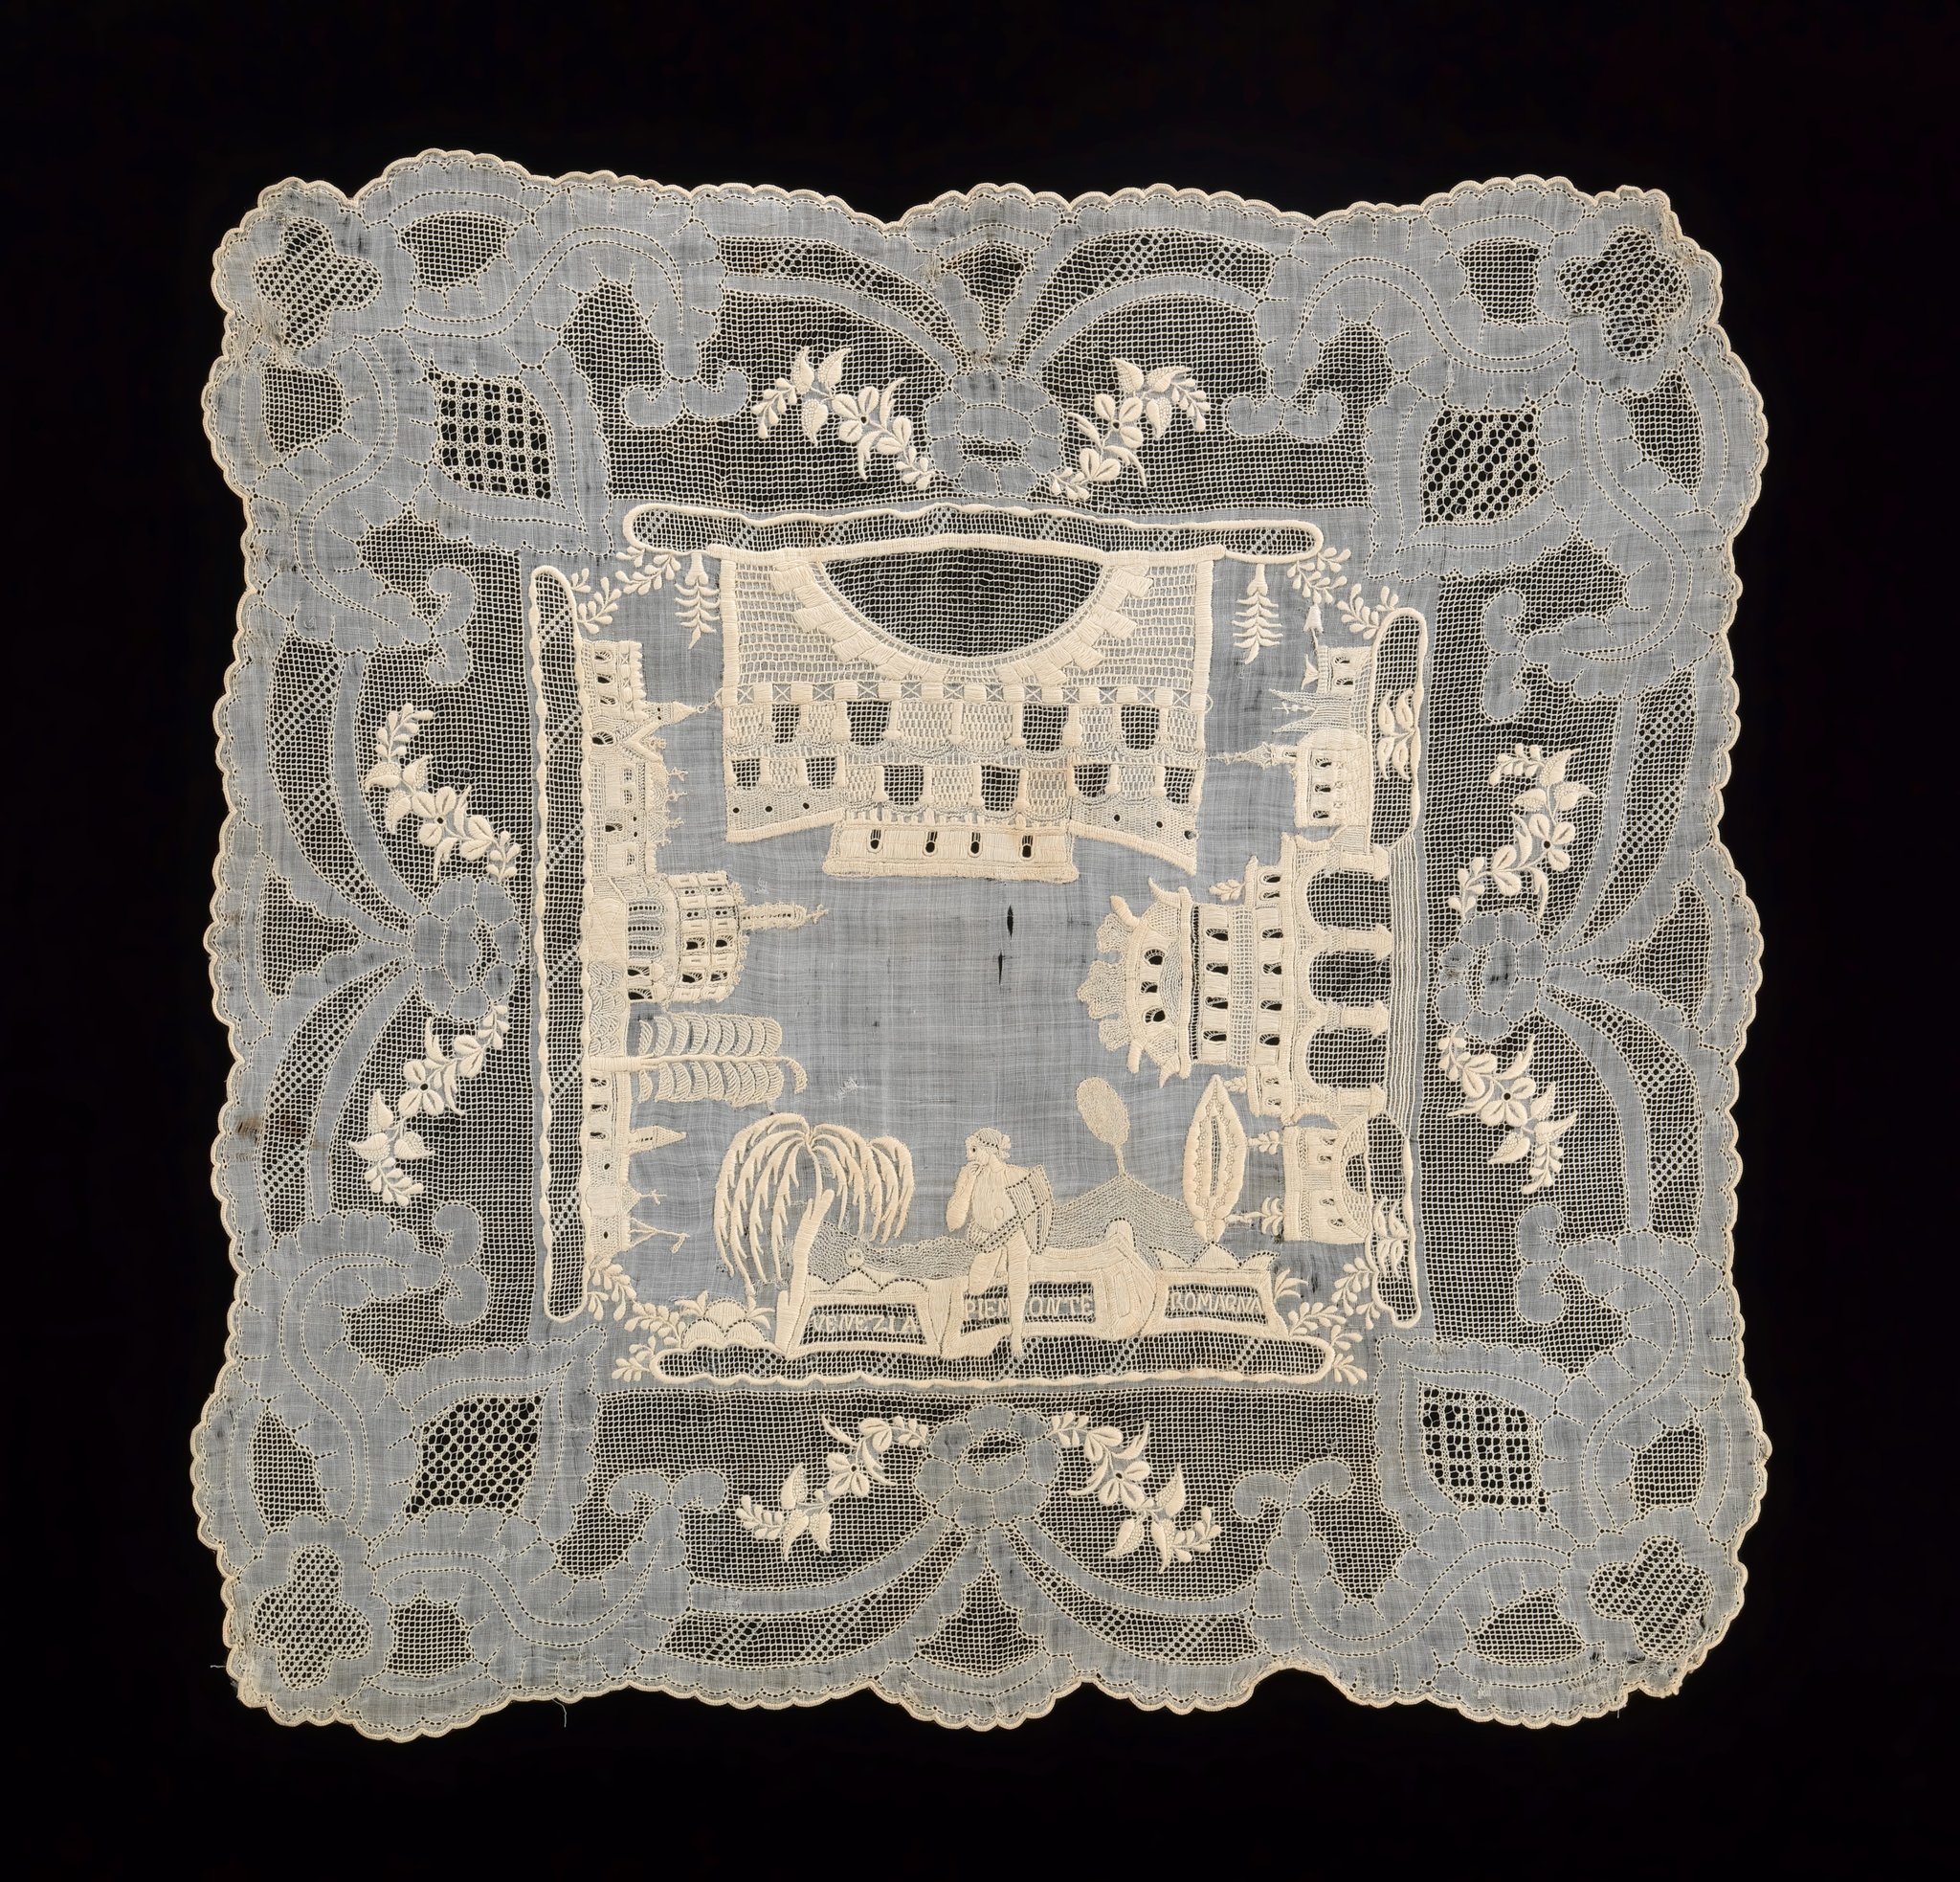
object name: handkerchief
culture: italian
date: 1851-1875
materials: linen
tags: monuments